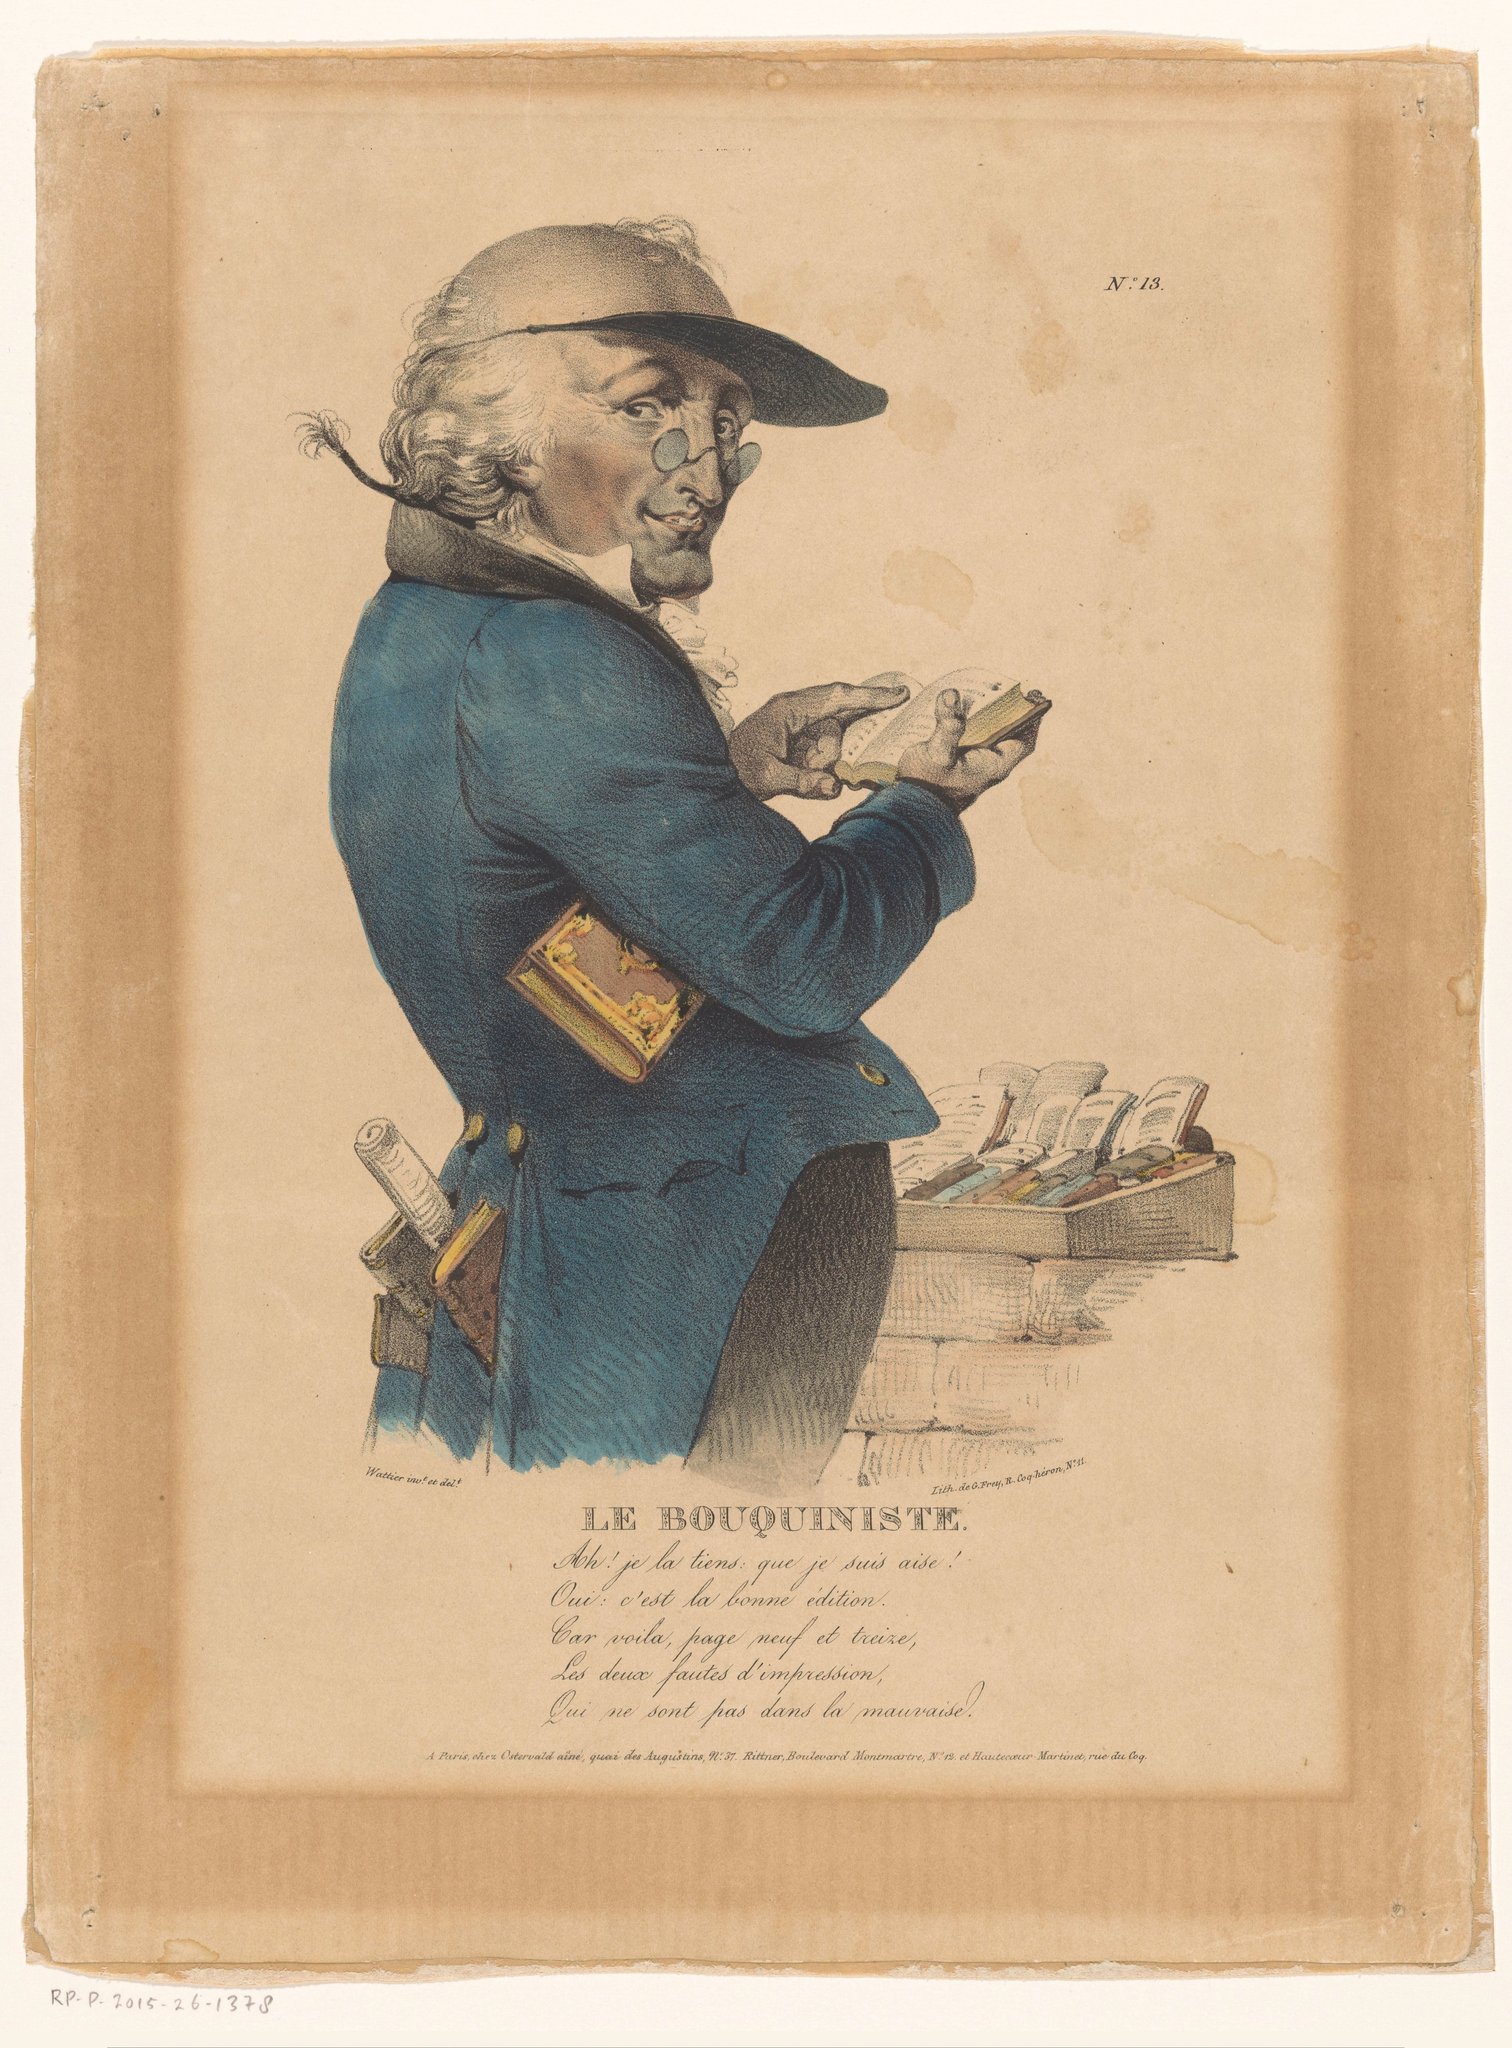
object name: print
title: Man bekijkt een boek voor een boekenkraam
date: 1828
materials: paper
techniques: hand coloring, lithograph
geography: paris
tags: book-stall, kiosk, book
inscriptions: collector's mark: Lugt 2228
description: Onder zijn arm klemt hij een boek en ook zijn jaszakken zitten vol boeken. Onder een vijfregelig vers in het Frans. Rechtsboven genummerd: No. 13.